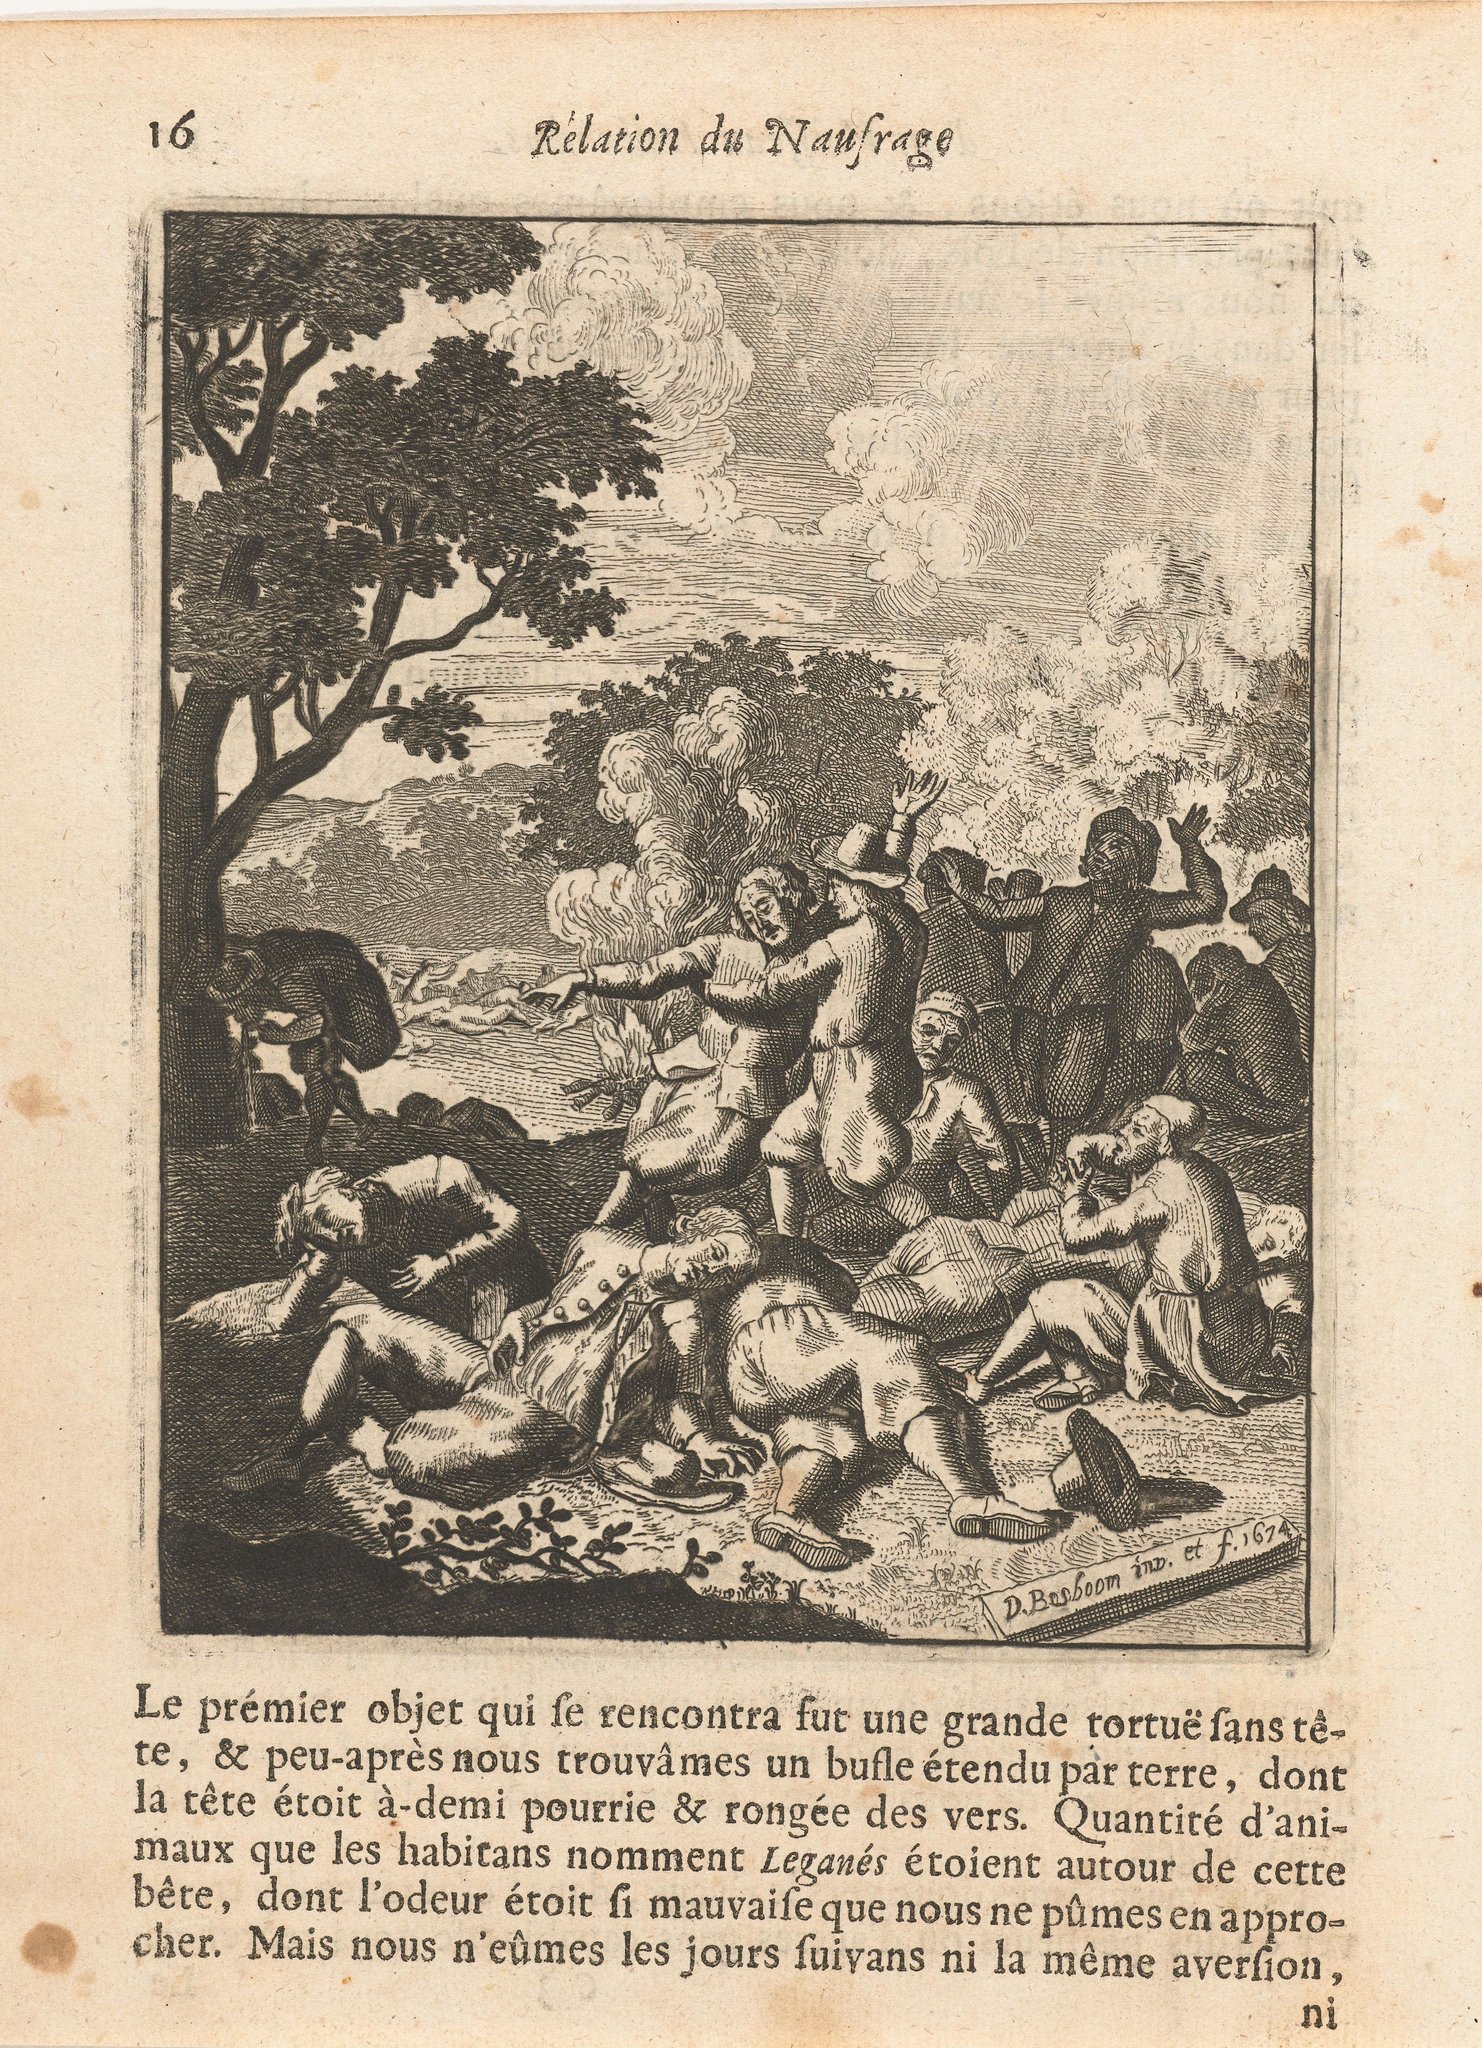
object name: book illustration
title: Groep matrozen is misselijk na het eten van vreemd voedsel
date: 1674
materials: paper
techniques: engraving, etching, letterpress printing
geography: amsterdam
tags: vomiting, diseases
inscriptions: collector's mark: Lugt 2760, collector's mark: Lugt 2228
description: De gestrande bemanning van het schipbreuk lijdende schip Terschelling eet gekookte schildpad en bladeren om niet van honger om te moeten komen. Sommigen zijn niet gewend aan het vreemde voedsel en worden misselijk. Bladzijde uit een boek, met illustratie en tekst op het recto en verso.